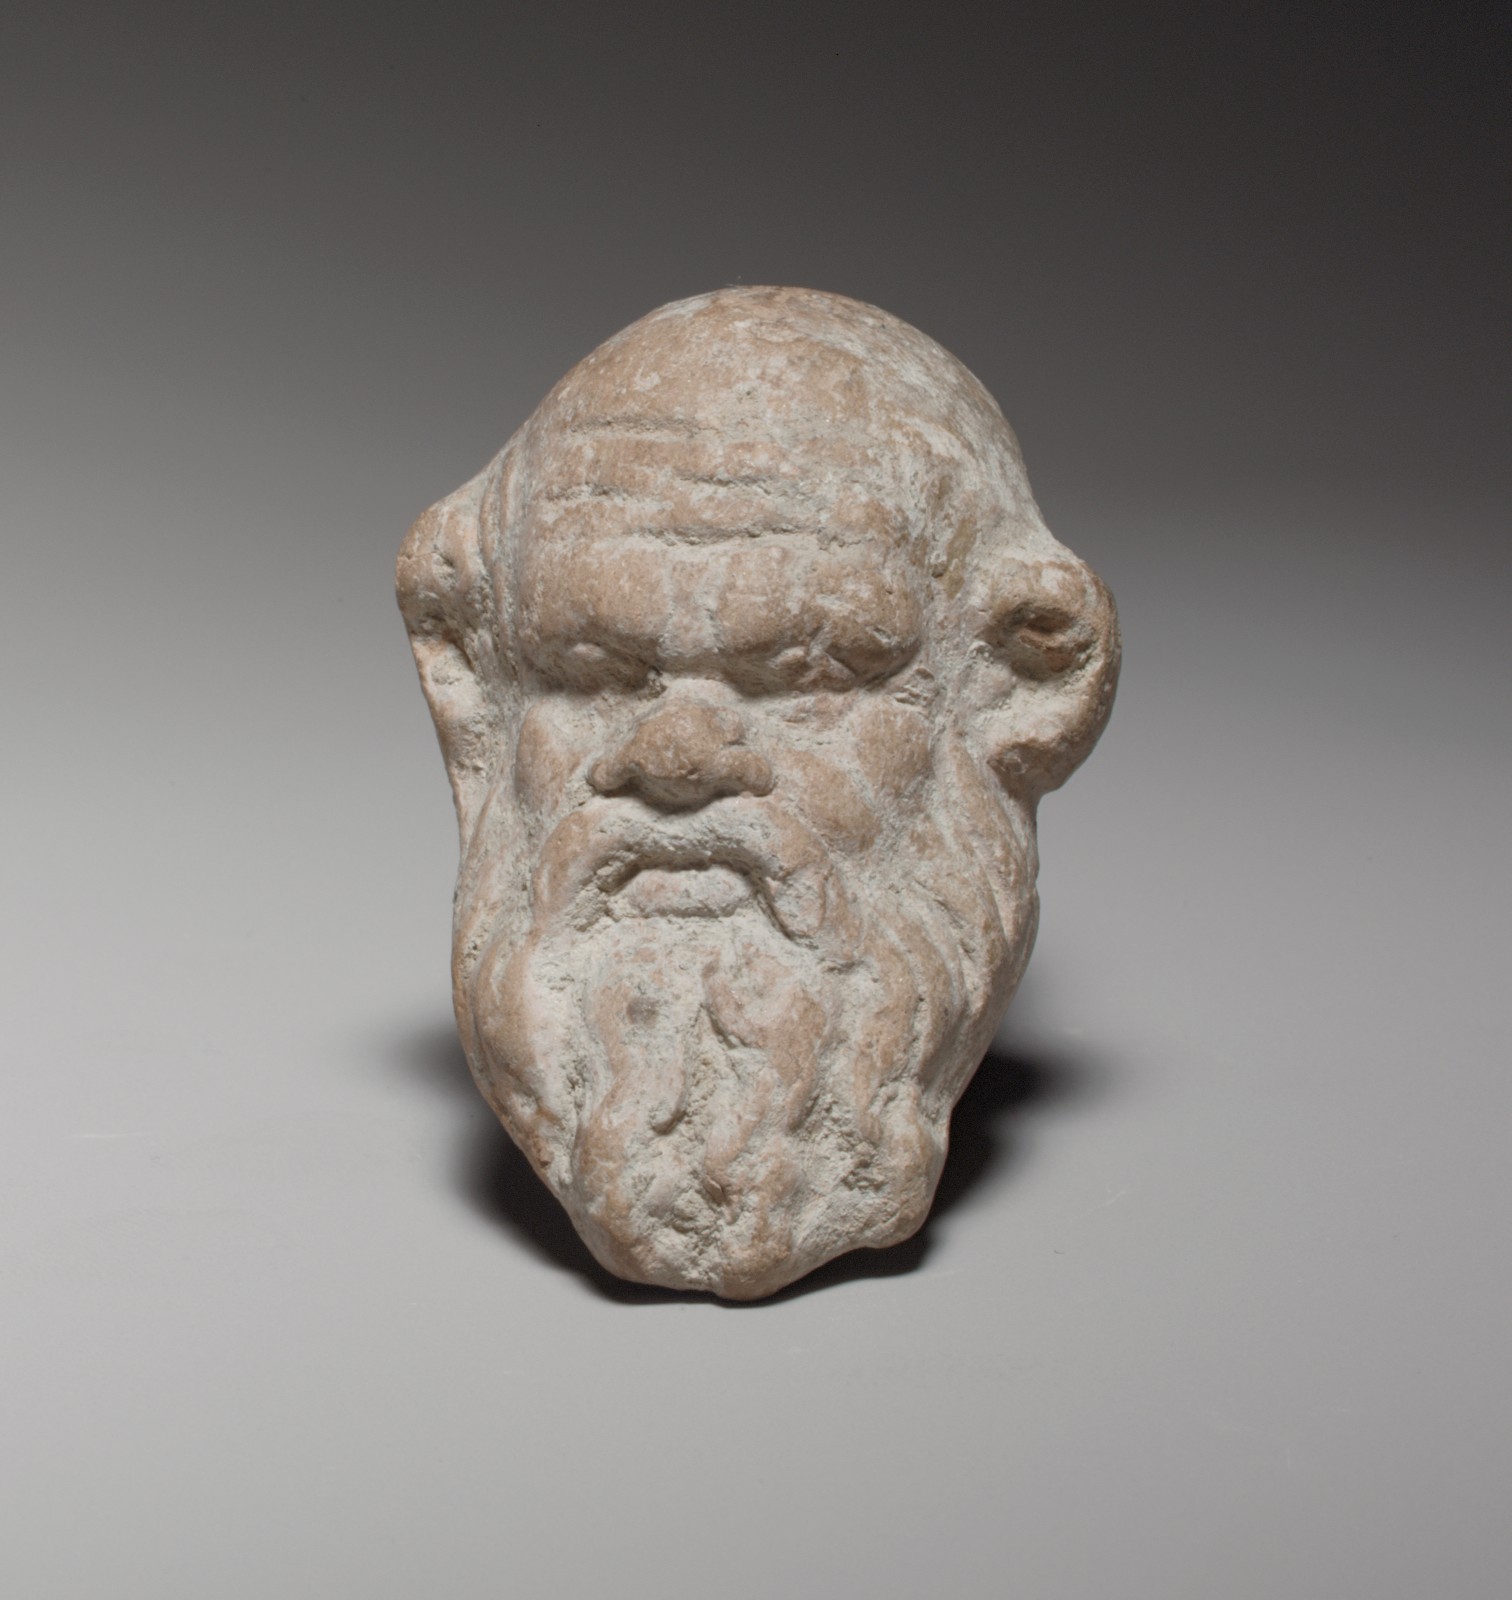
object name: head of silenos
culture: cypriot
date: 200-101 BCE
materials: terracotta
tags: heads,silenus